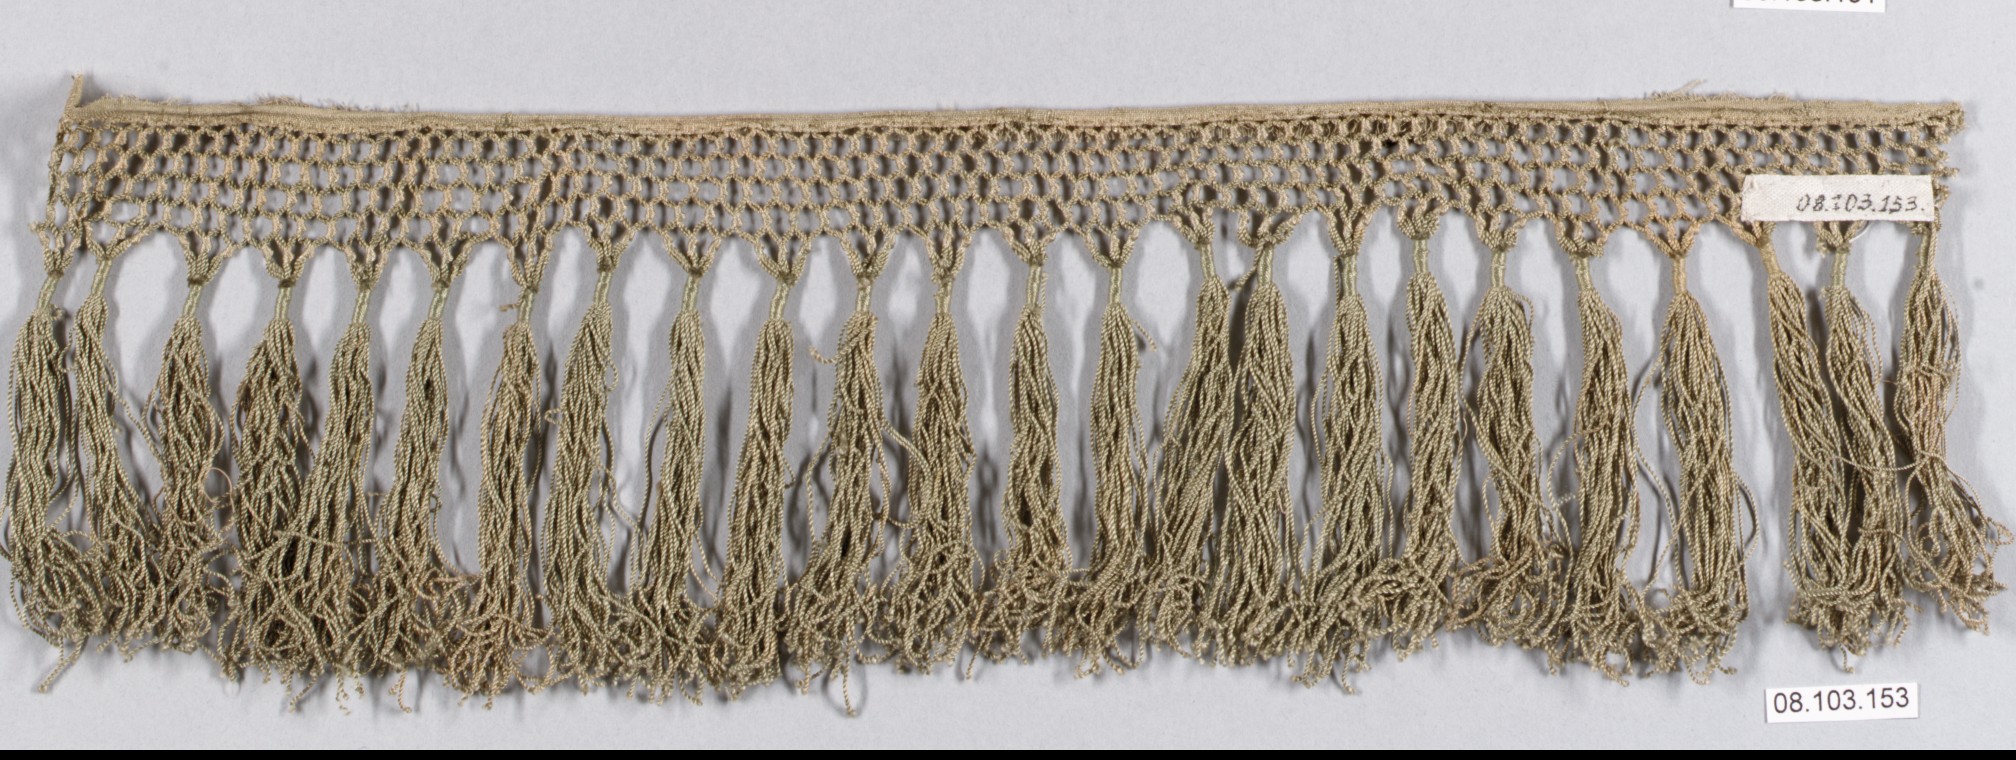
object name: fringe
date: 1801-1900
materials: silk